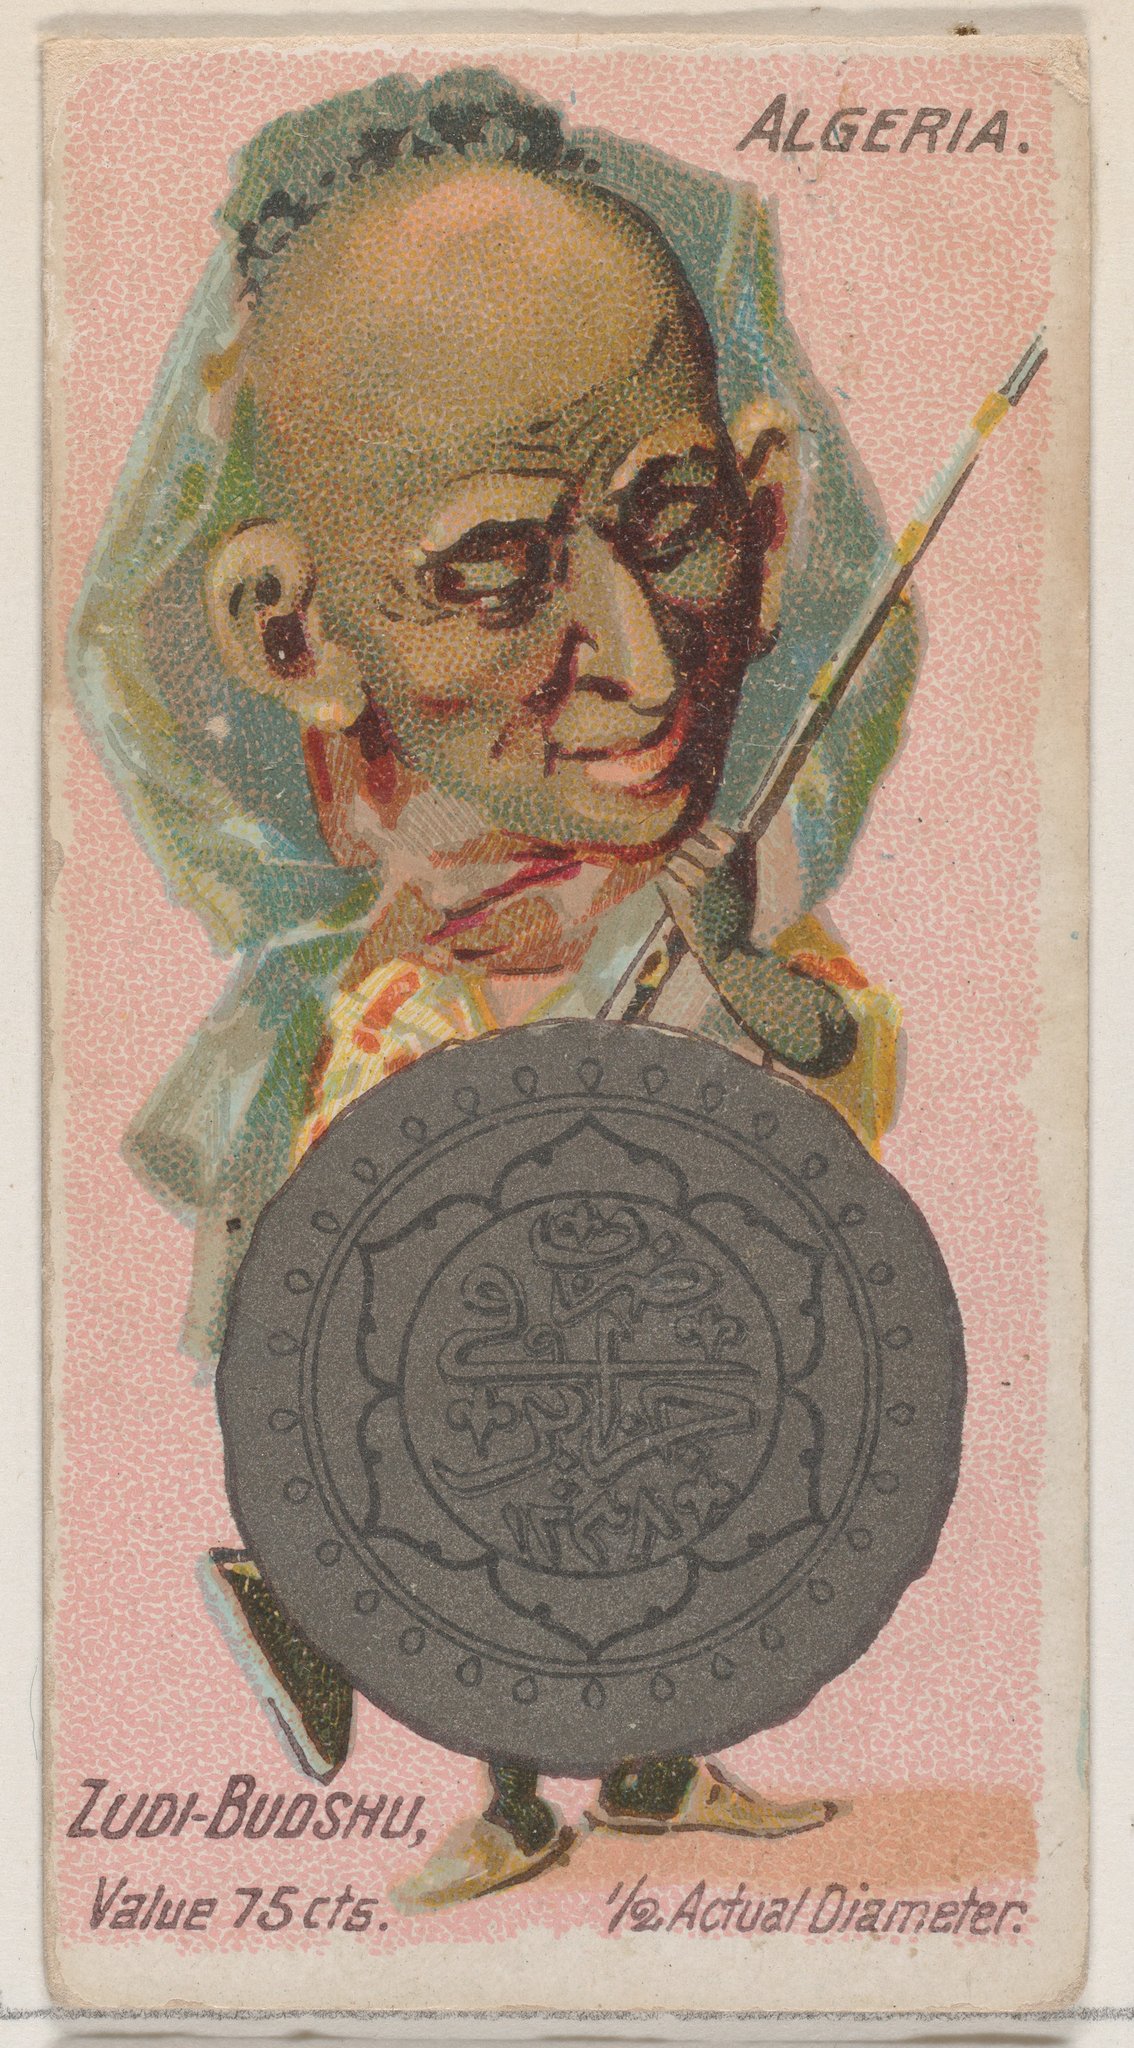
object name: print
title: Caricatured Algerian, Zudi-Budshu, from the series Coins of All Nations (N72, variation 2) for Duke brand cigarettes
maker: w. duke, sons & co.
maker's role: publisher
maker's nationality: american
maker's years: 1870-1920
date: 1889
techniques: color lithograph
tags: men,coins